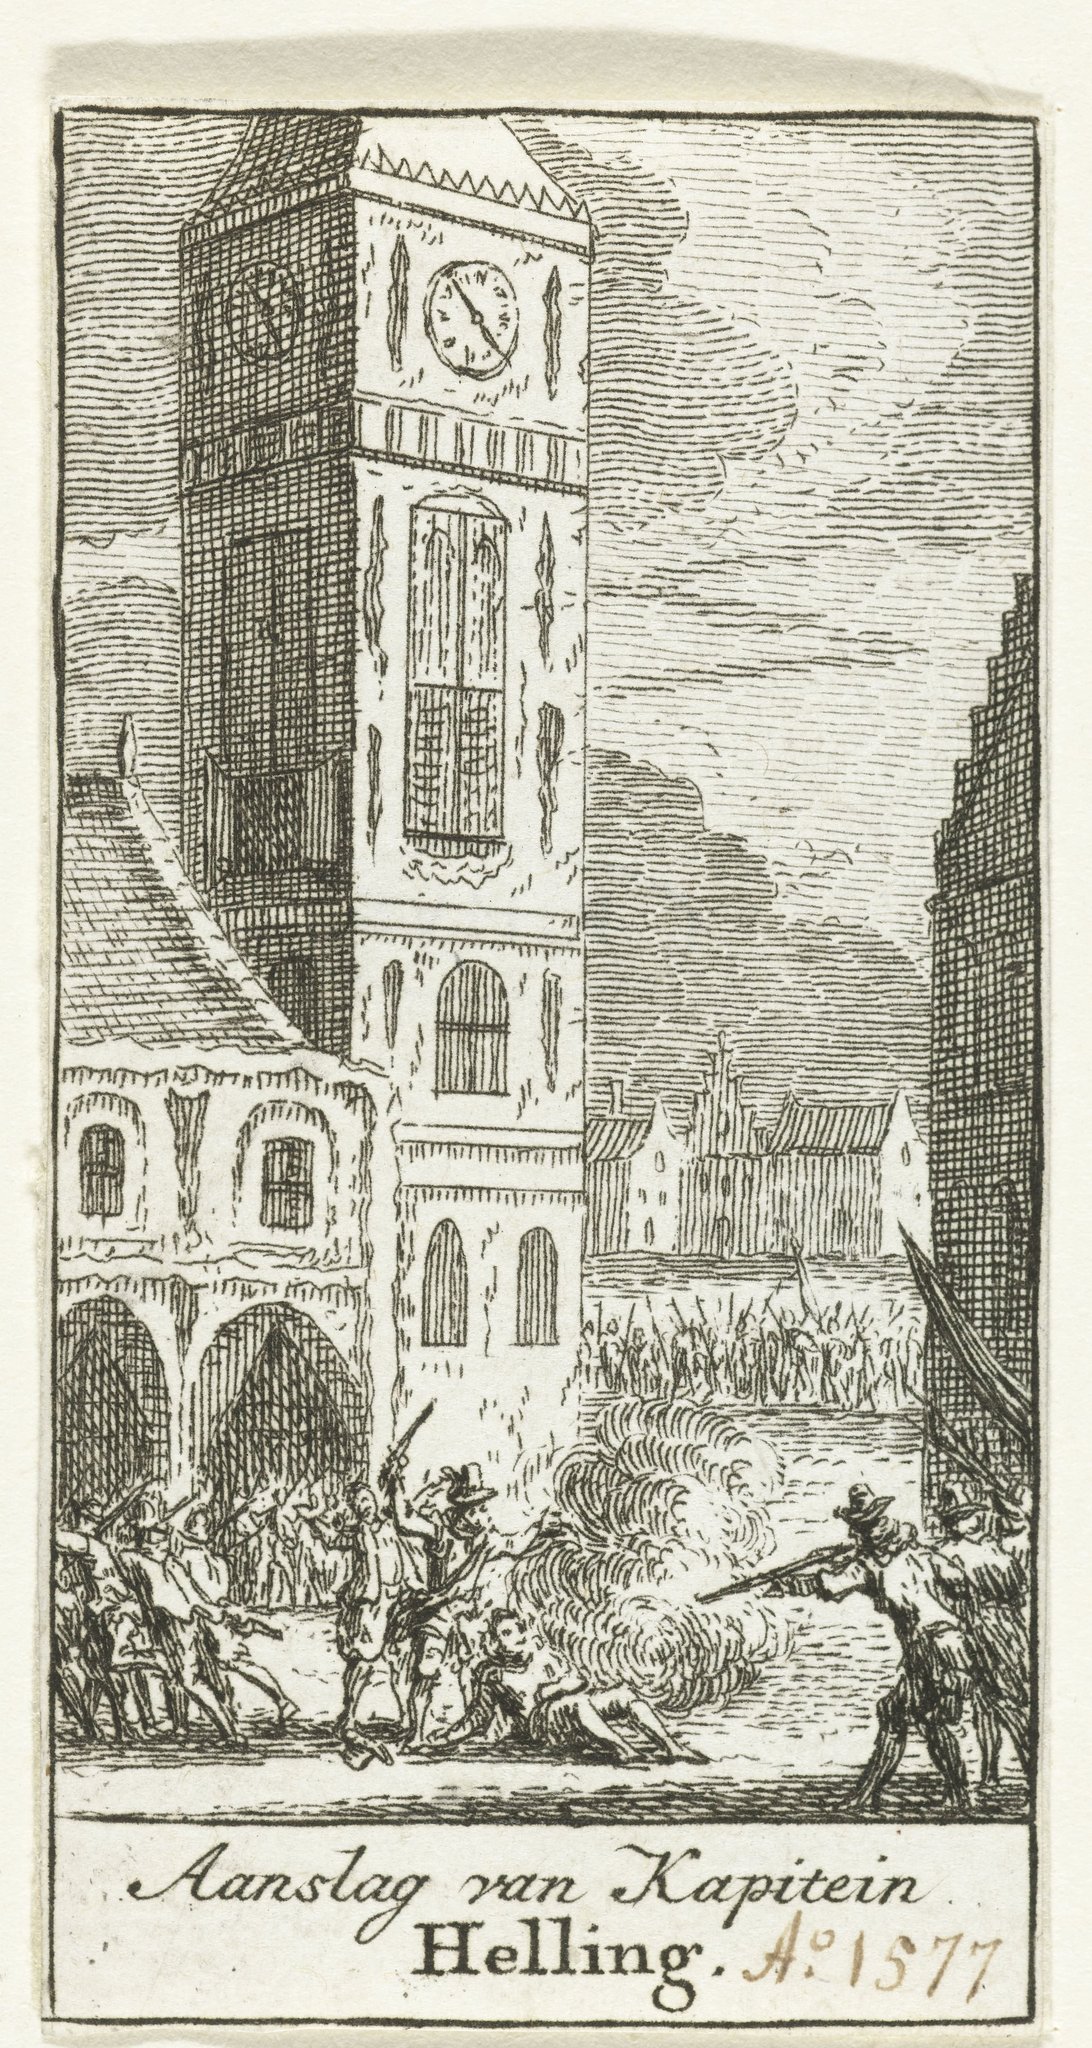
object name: print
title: Aanslag van Helling op Amsterdam, 1577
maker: simon fokke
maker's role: draughtsman, print maker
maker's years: 1712-1784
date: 1722-1784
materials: paper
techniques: etching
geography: northern netherlands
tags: haarlem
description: Aanslag van Helling en Ruychaver op Amsterdam, 23 november 1577. Gevechten op de Dam voor het stadhuis.